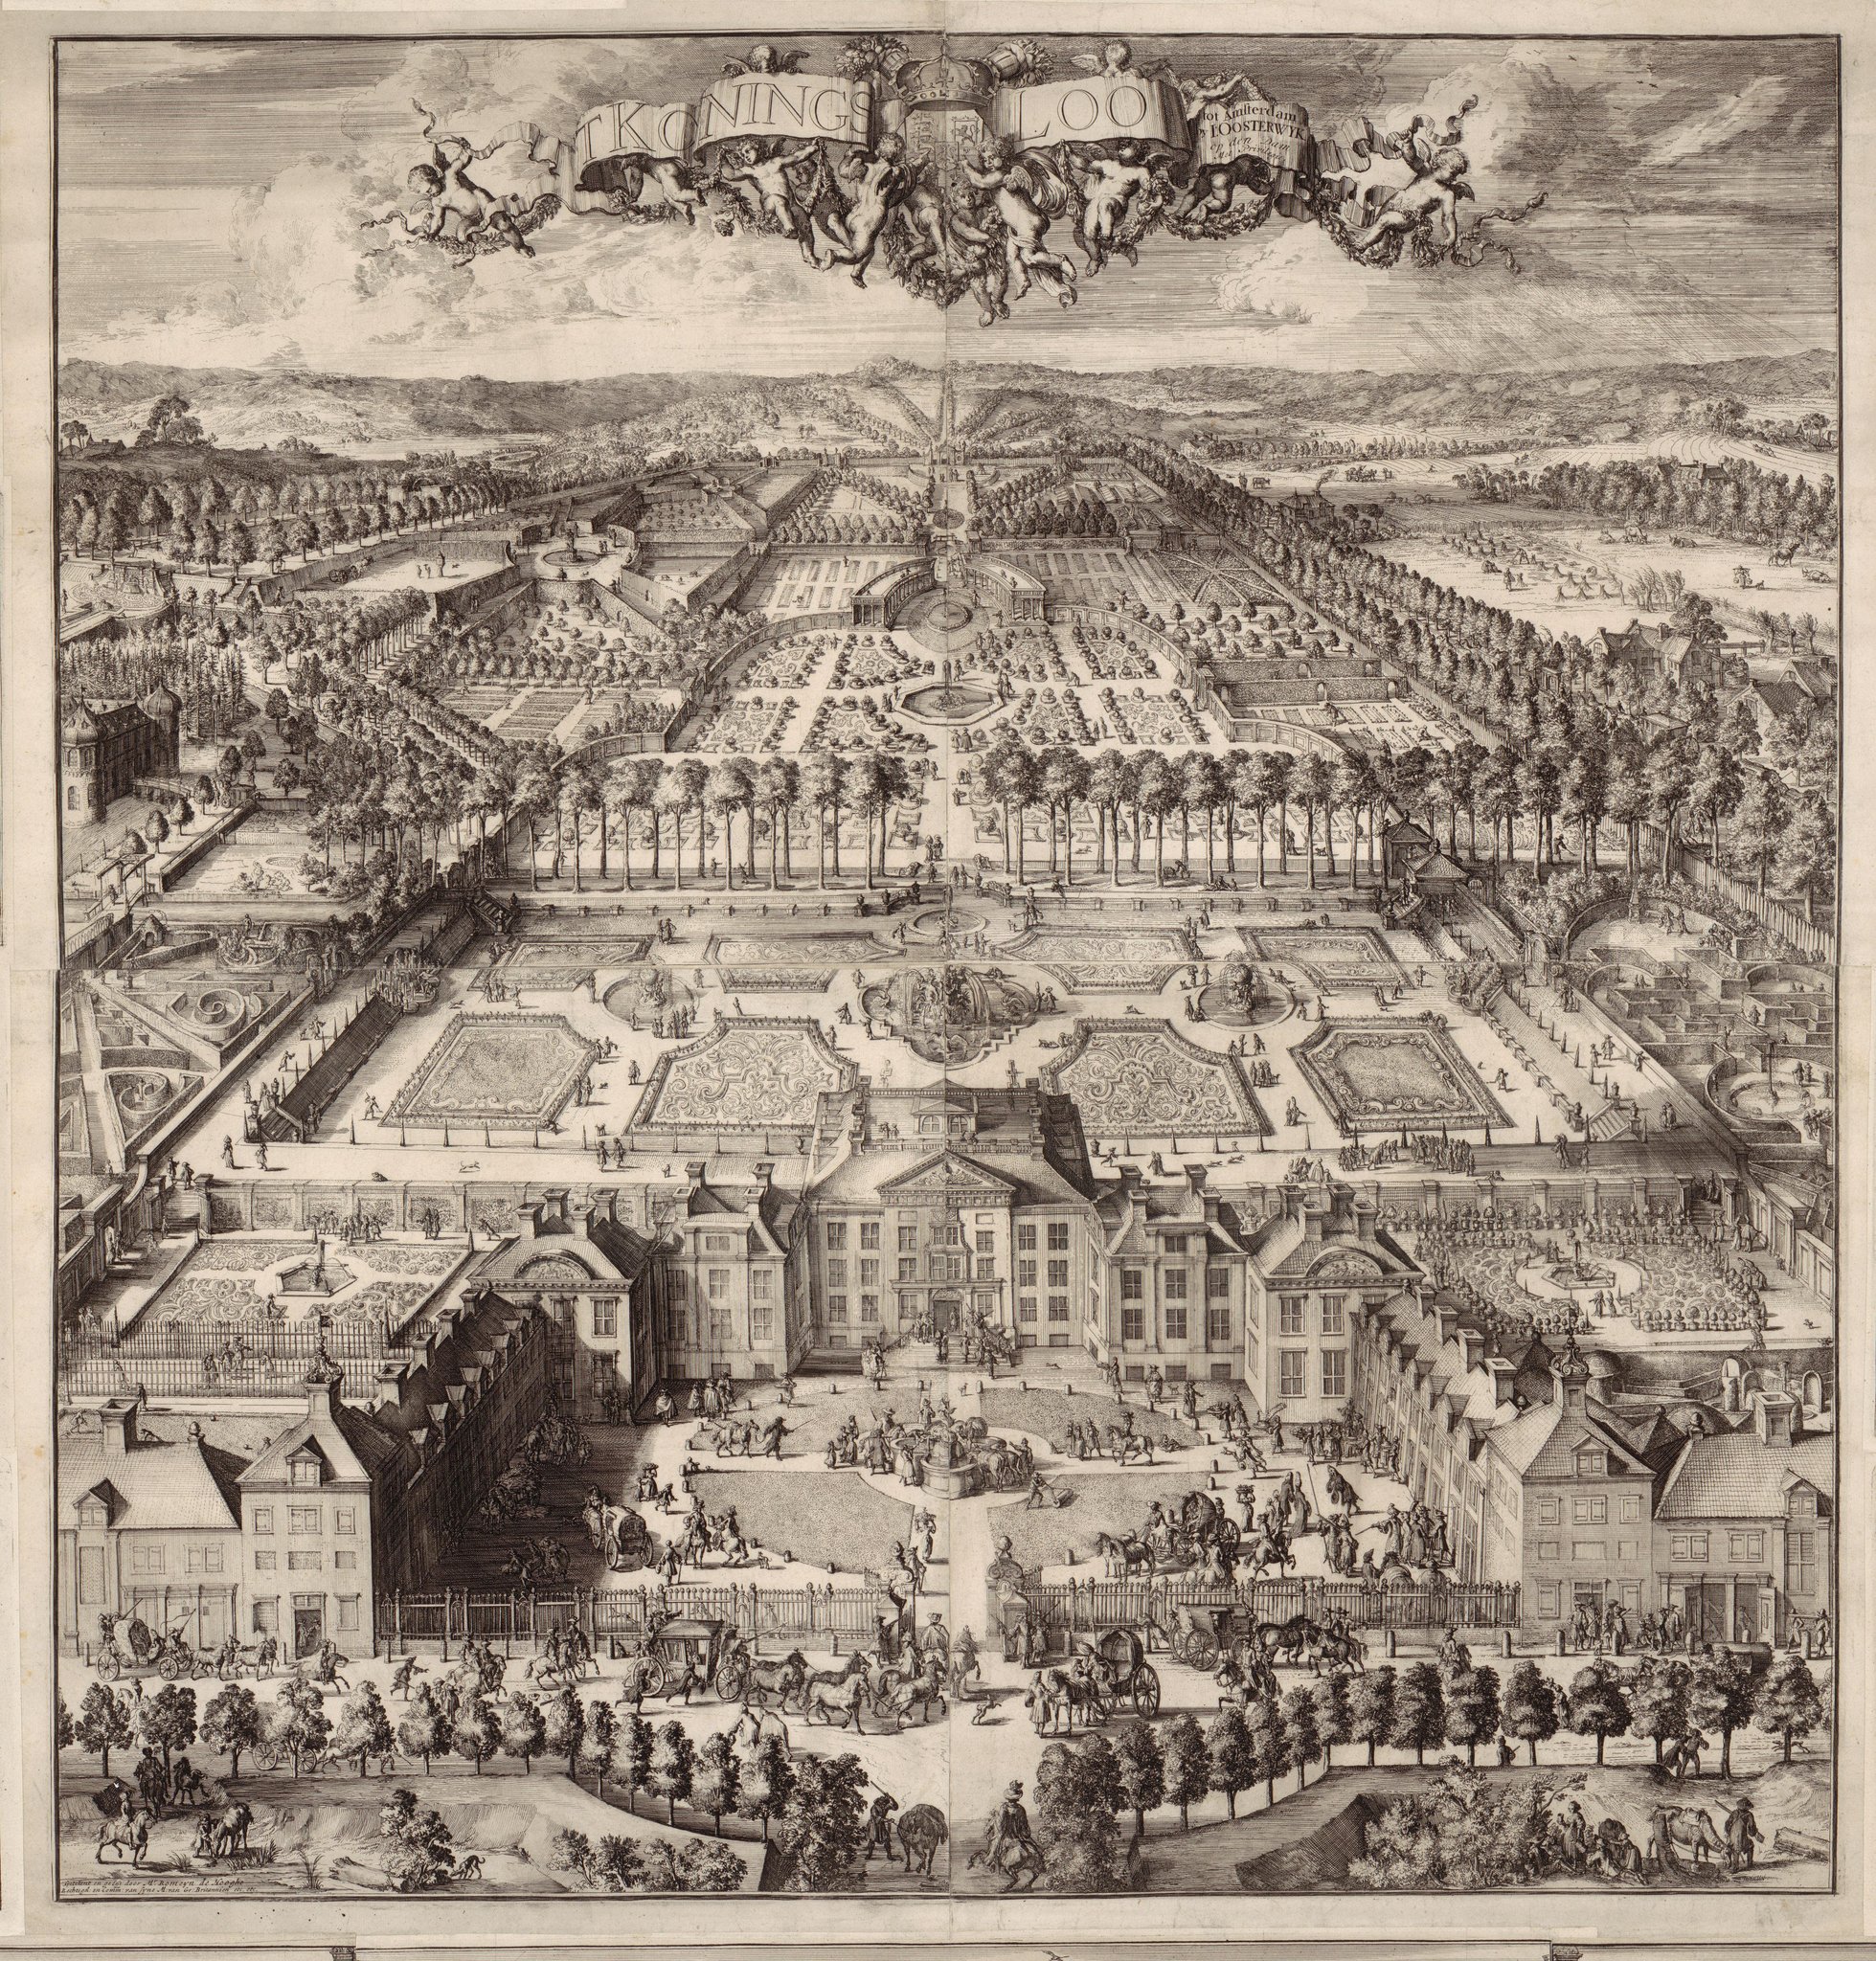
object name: print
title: 'T Konings loo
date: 1690-1694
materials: paper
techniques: etching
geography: amsterdam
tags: the hague, william iii (prince of orange and king of england, scotland, and ireland), garden, garden fountain, four-wheeled, animal-drawn vehicle, e.g.: cab, carriage, coach, palace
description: Gezicht op Paleis Het Loo en omgeving vanuit vogelvluchtperspectief, op 4 bladen. Deze bladen maken deel uit van een omvangrijke prent met een gezicht op Paleis Het Loo, omgeven door dertien gezichten op de bijbehorende gebouwen en het bijbehorende park (boven, links, rechts), en een profiel van het paleis (onder).